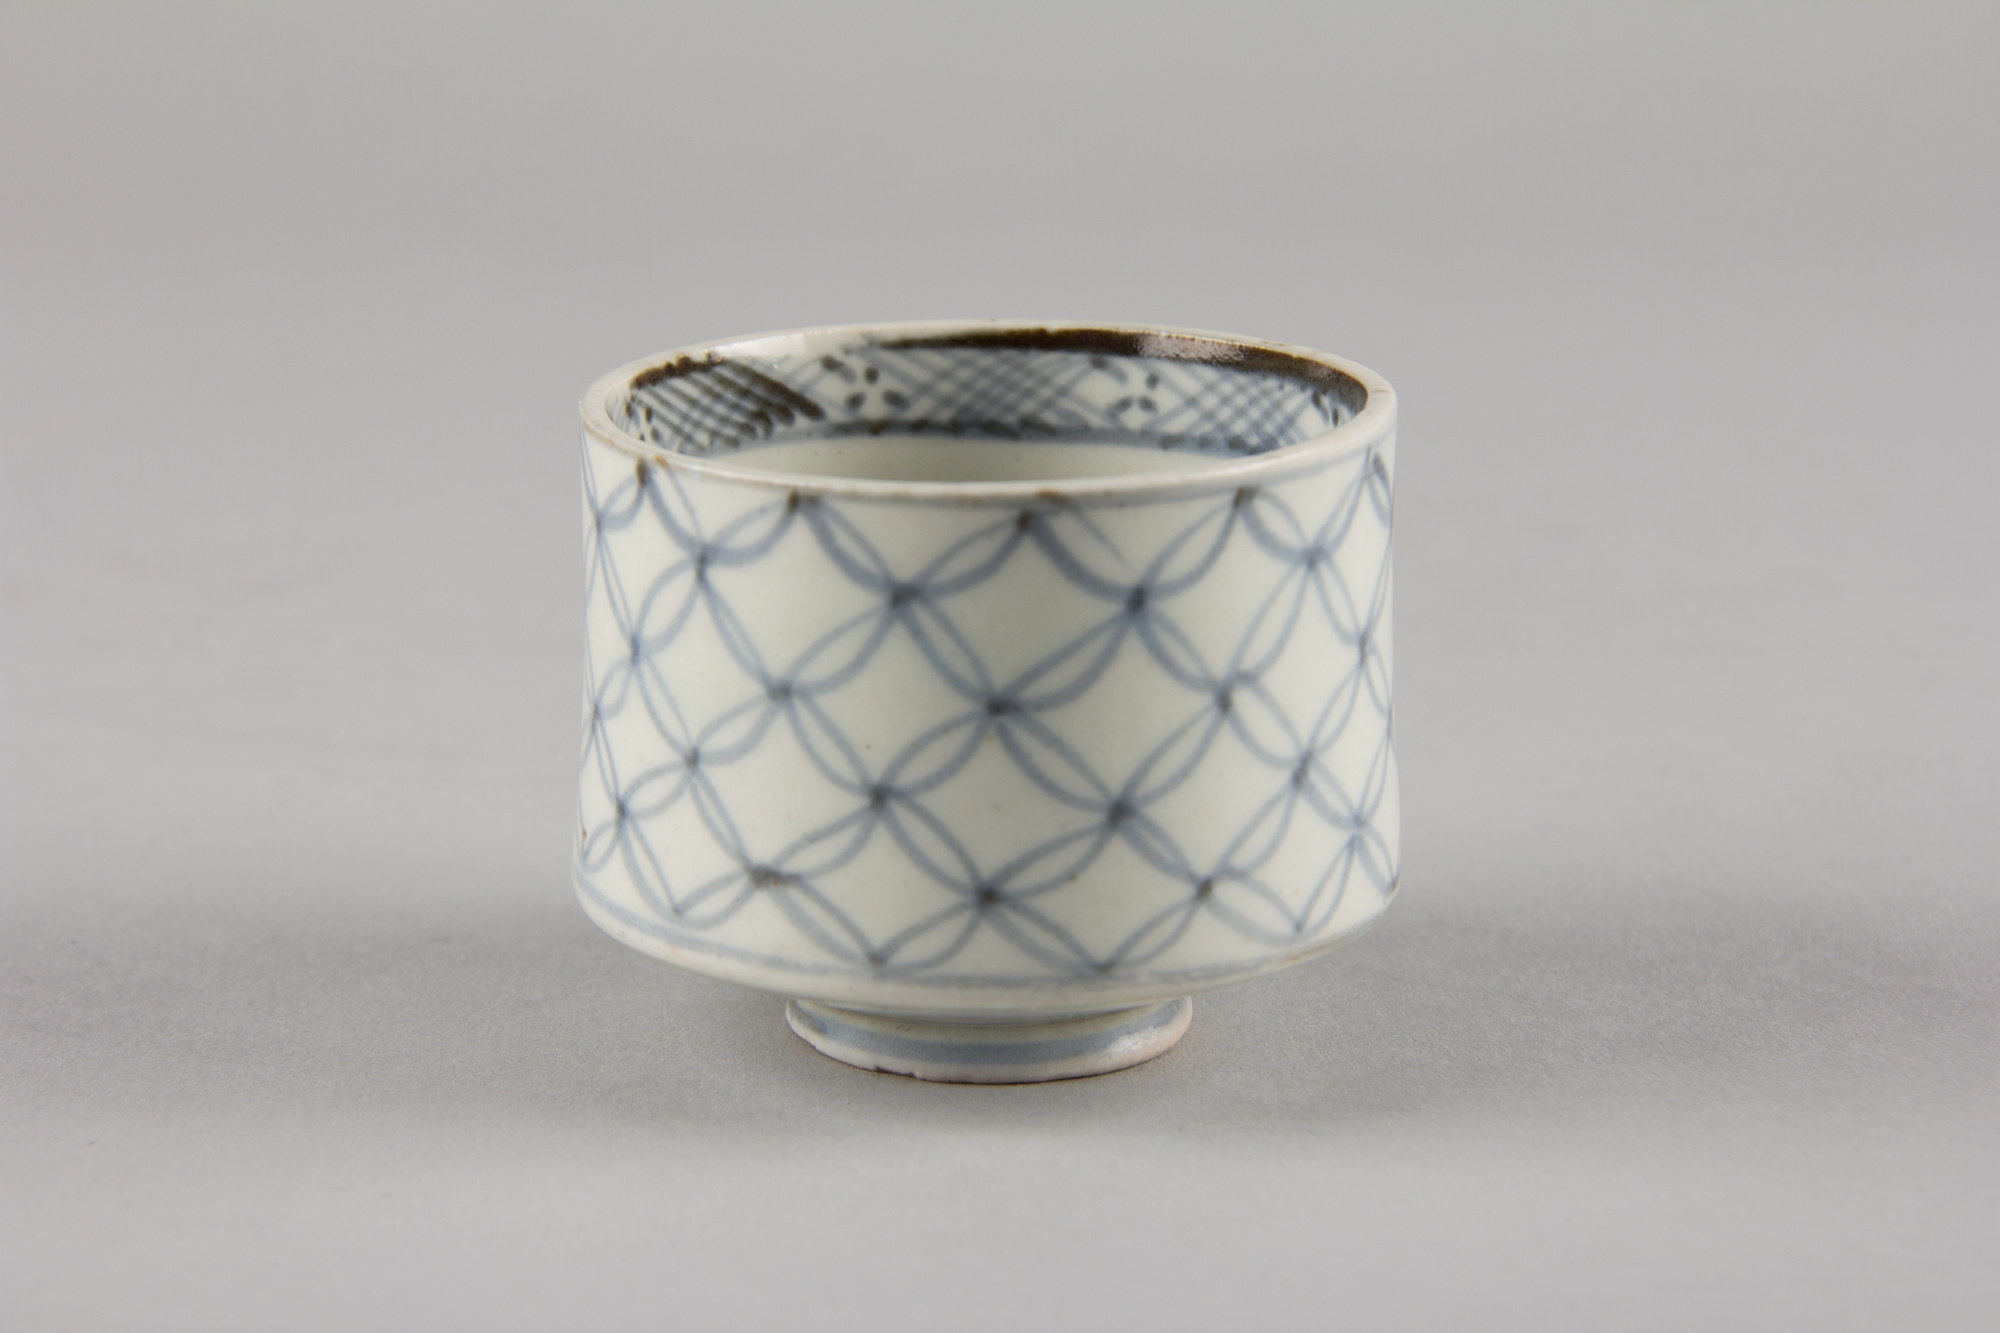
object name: soba cup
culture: japanese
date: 1700-1750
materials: porcelain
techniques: underglaze